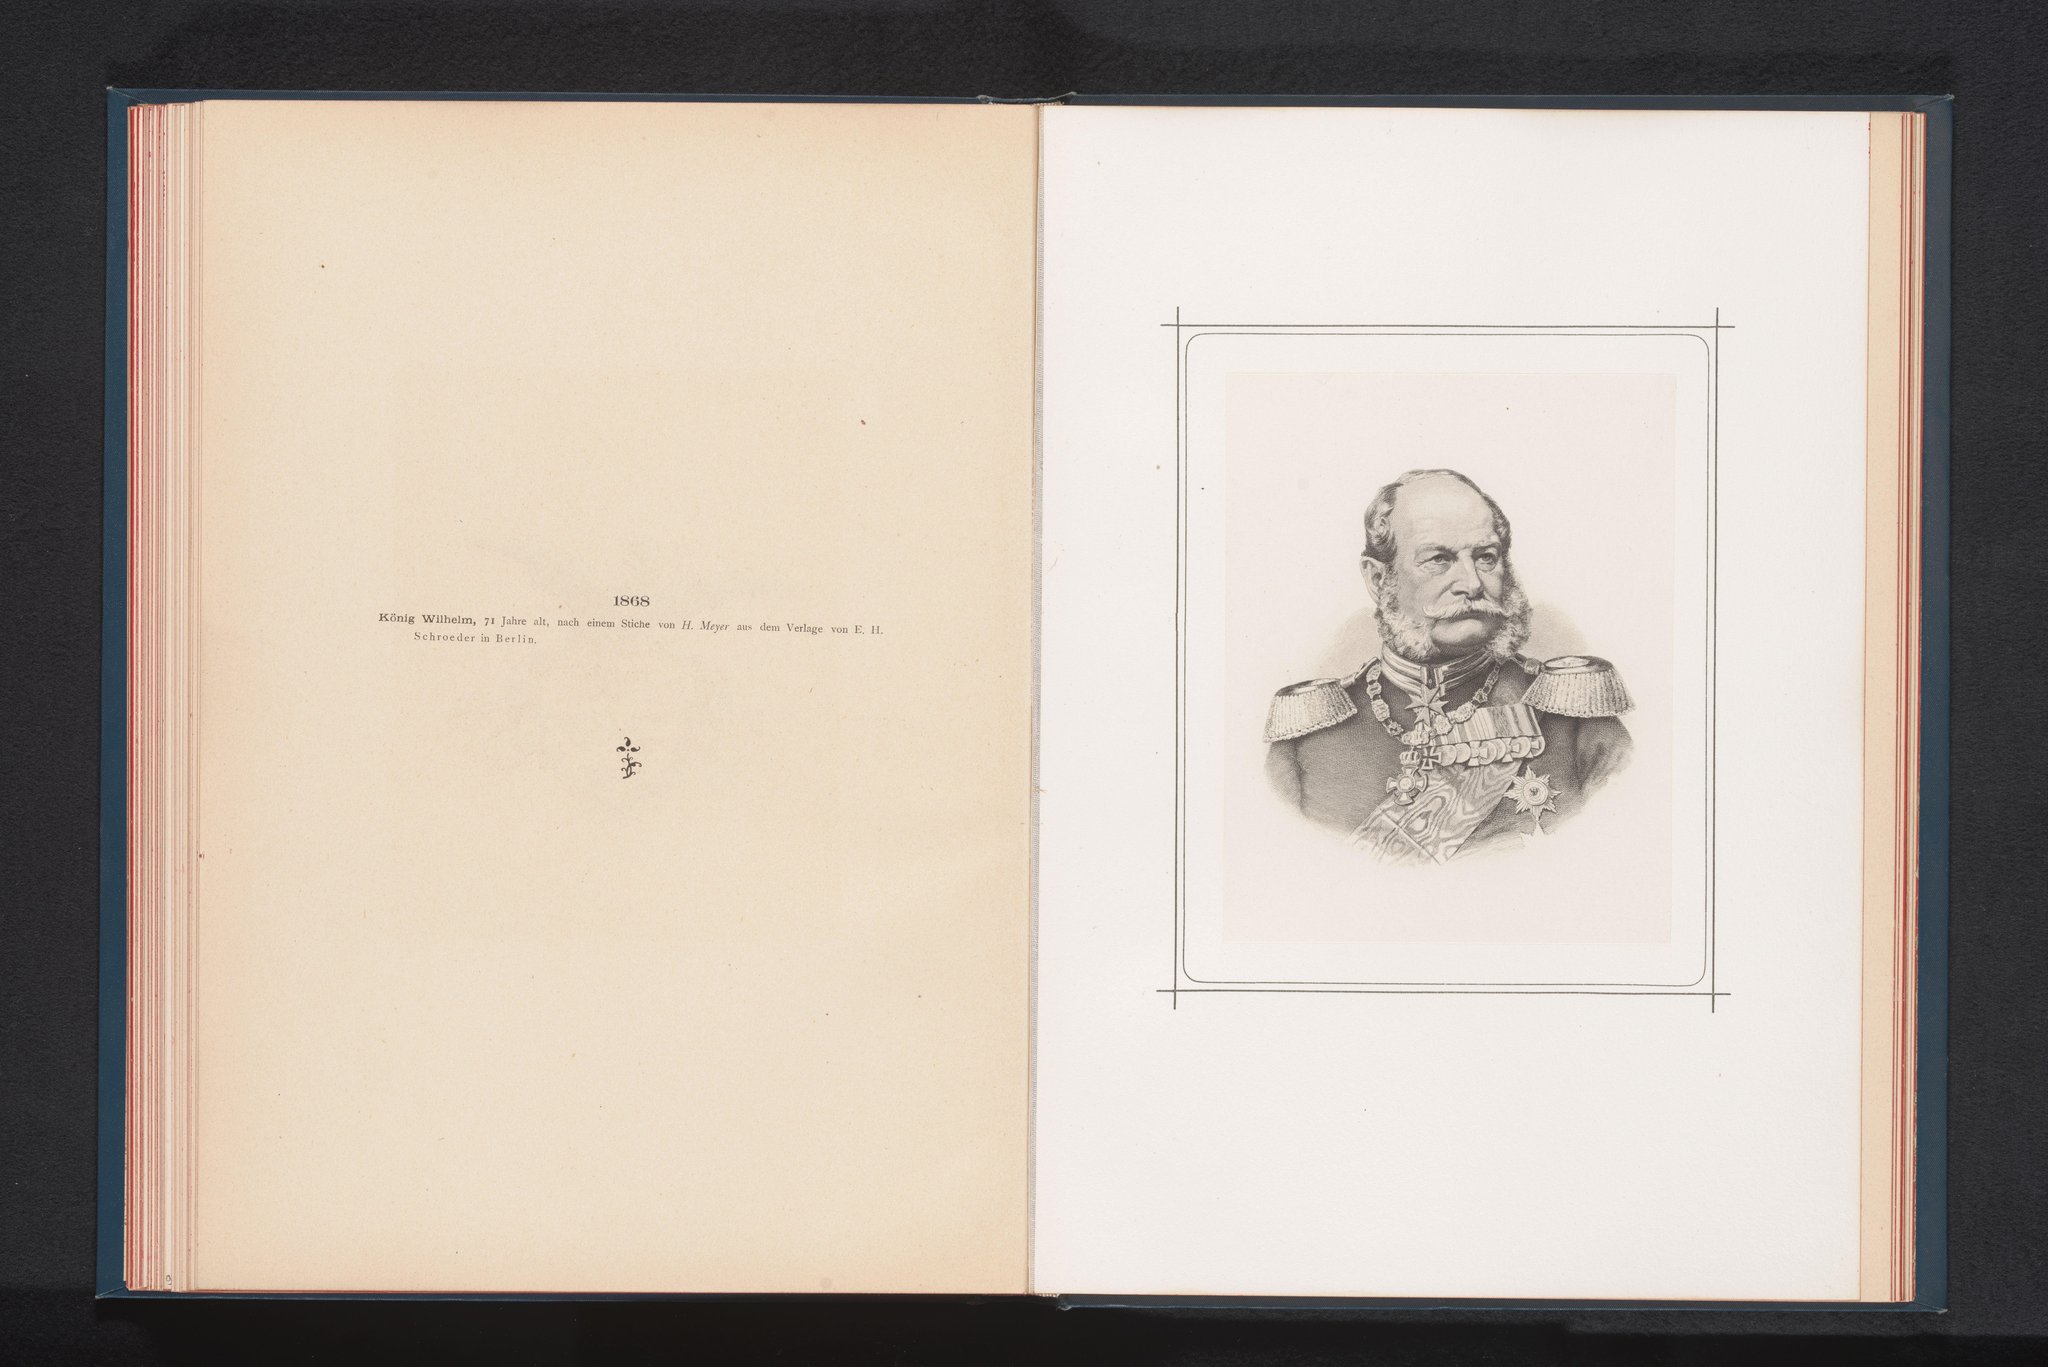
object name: reproduction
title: Fotoreproductie van een portret van Wilhelm I op een leeftijd van 71 jaar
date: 1887-1897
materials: paper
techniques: photograph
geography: germany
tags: berlin, wilhelm i (keizer van duitsland), ruler, sovereign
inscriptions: inscription: ‘1868 König Wilhelm, 71 Jahre alt, nach einem Stiche von H. Meyer aus dem Verlage von E.H. Schroeder in Berlin.’